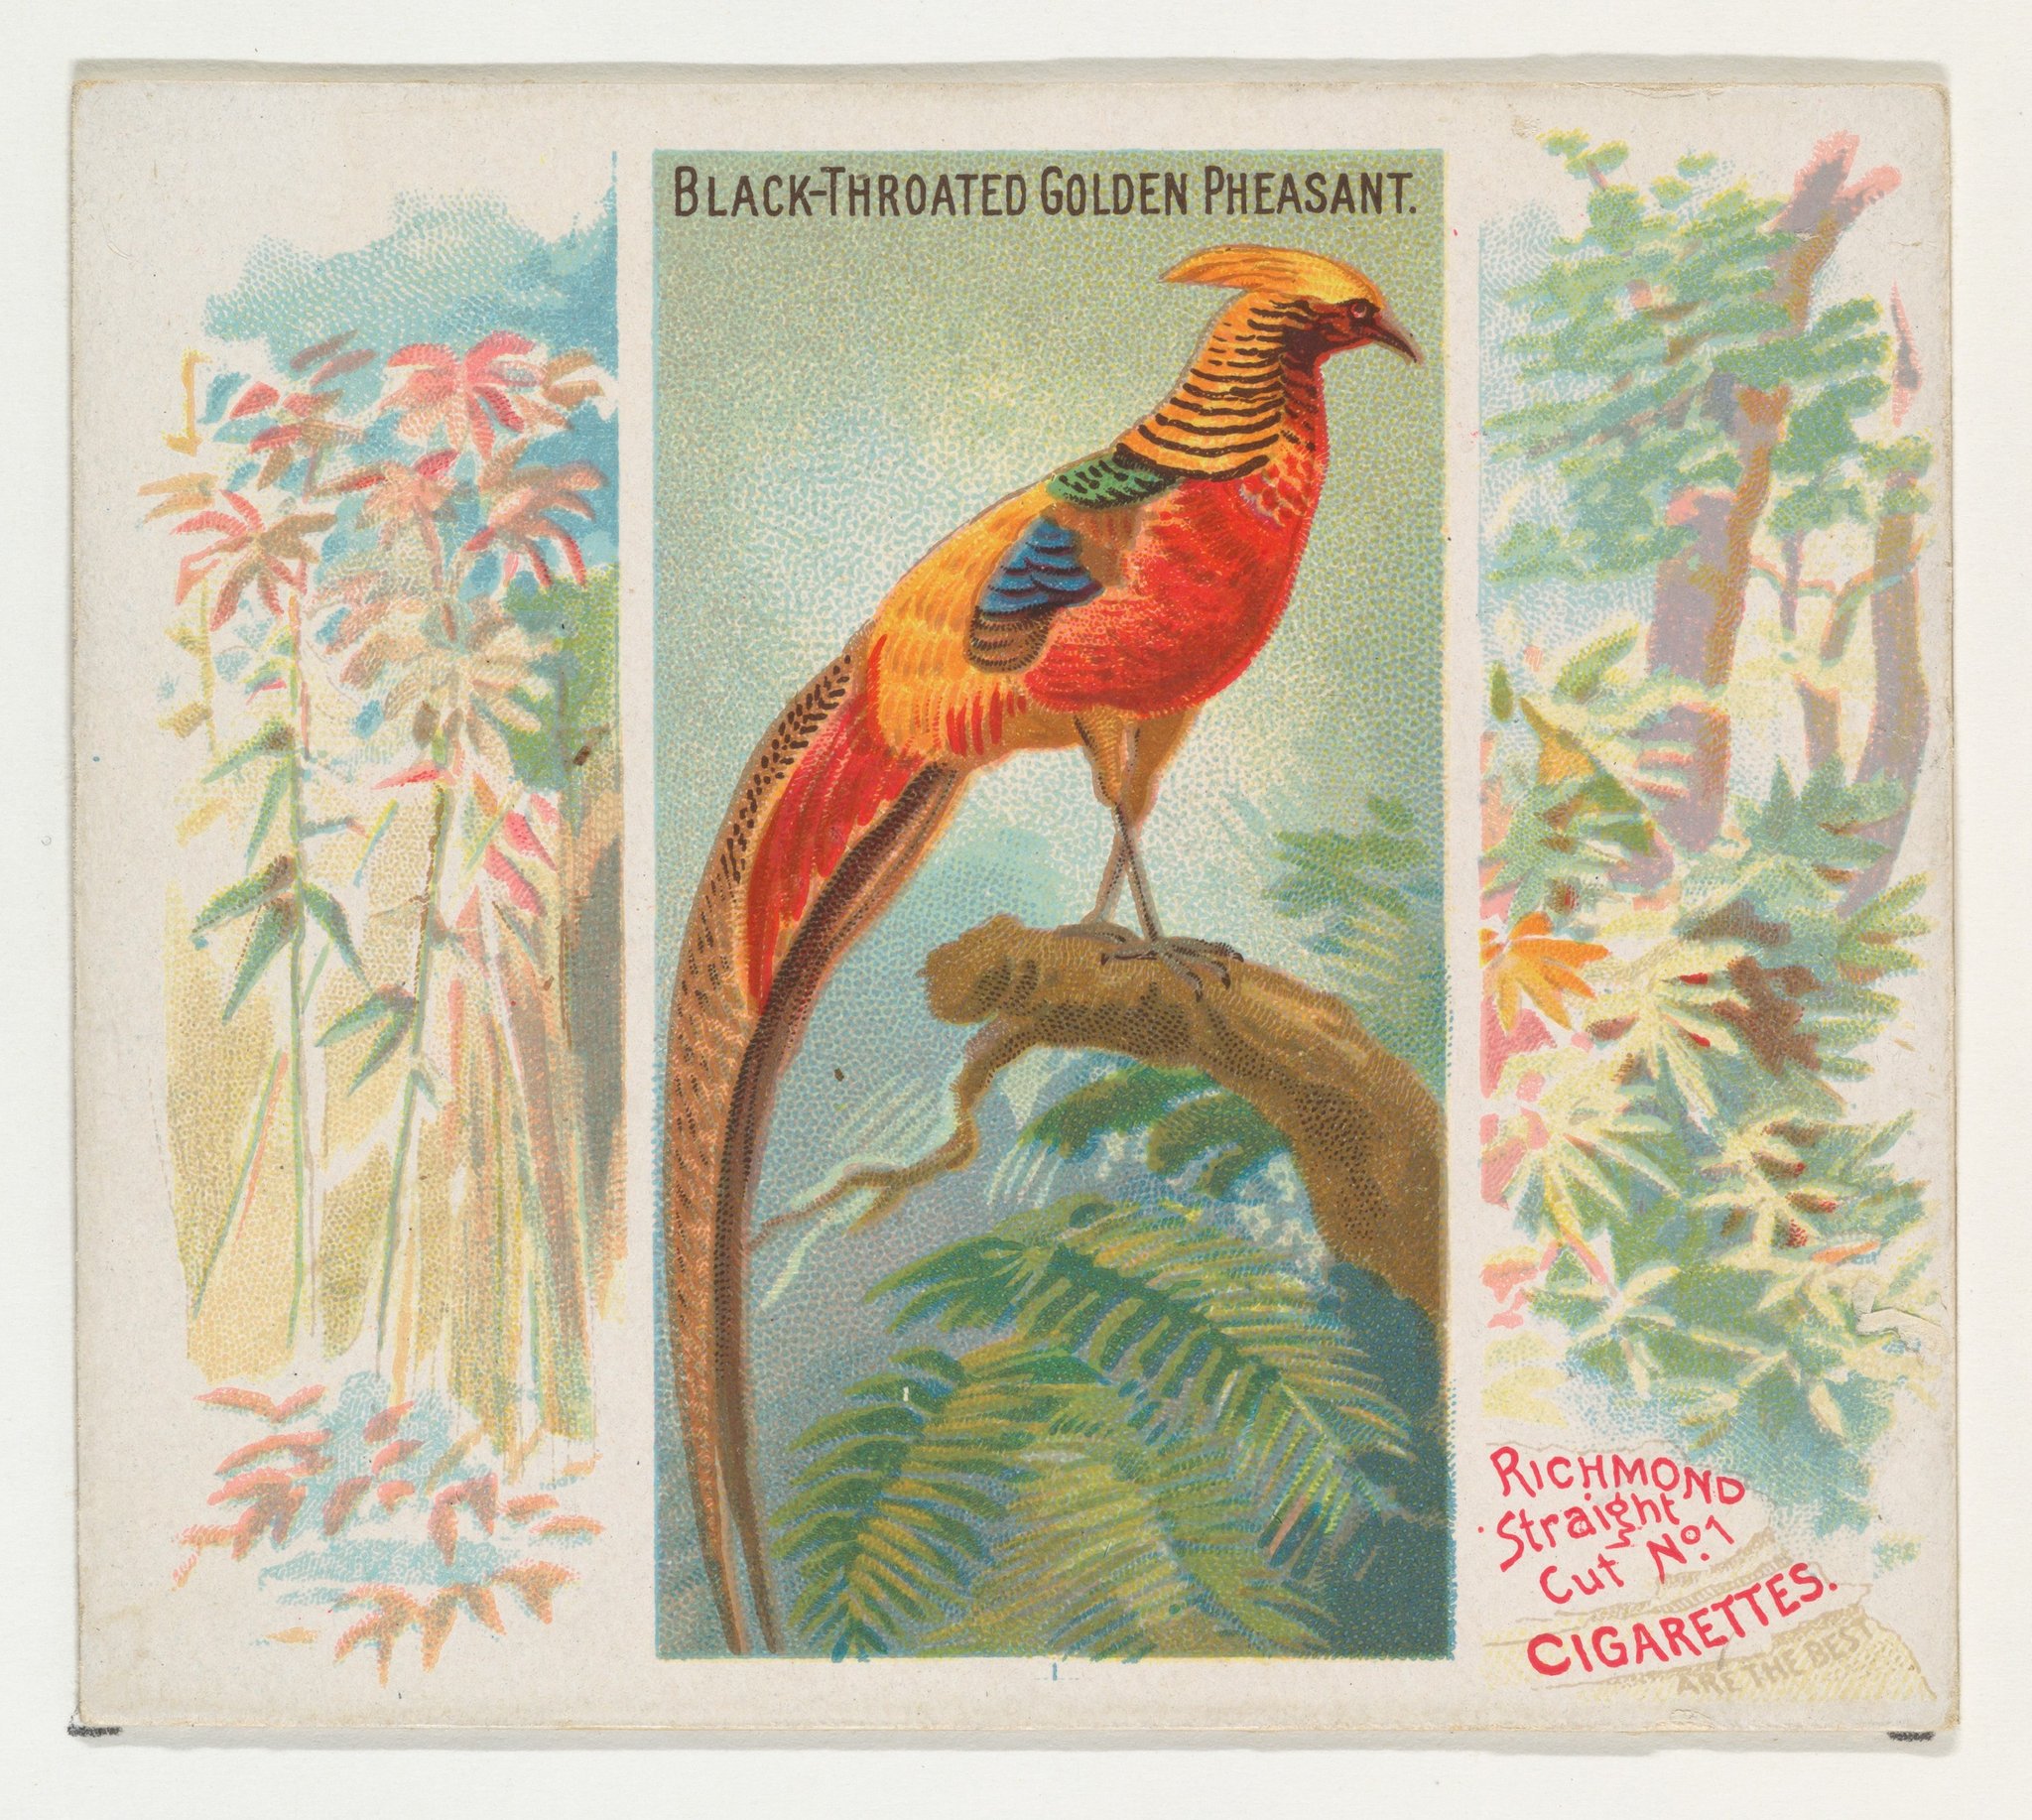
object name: print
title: Black-Throated Golden Pheasant, from Birds of the Tropics series (N38) for Allen & Ginter Cigarettes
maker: allen & ginter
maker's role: publisher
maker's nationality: american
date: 1889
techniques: color lithograph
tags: pheasants